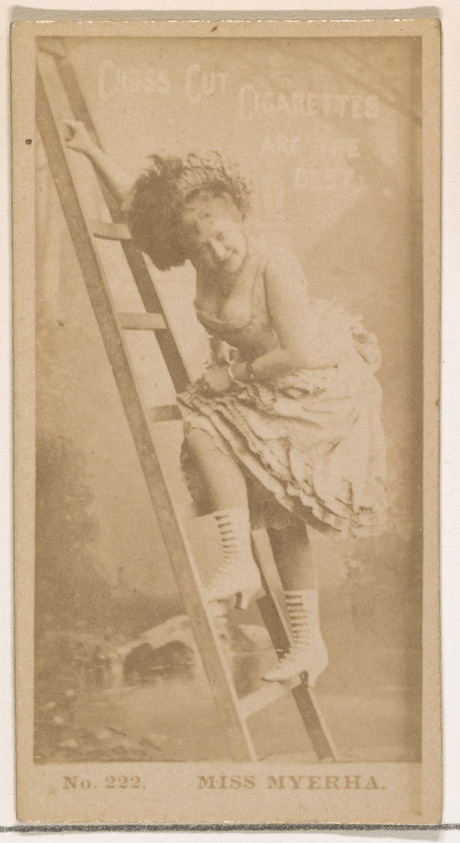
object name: print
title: Card Number 222, Miss Myerha, from the Actors and Actresses series (N145-2) issued by Duke Sons & Co. to promote Cross Cut Cigarettes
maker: w. duke, sons & co.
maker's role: publisher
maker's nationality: american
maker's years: 1870-1920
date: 1880-1889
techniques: albumen silver print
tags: portraits,women,actresses,ladders